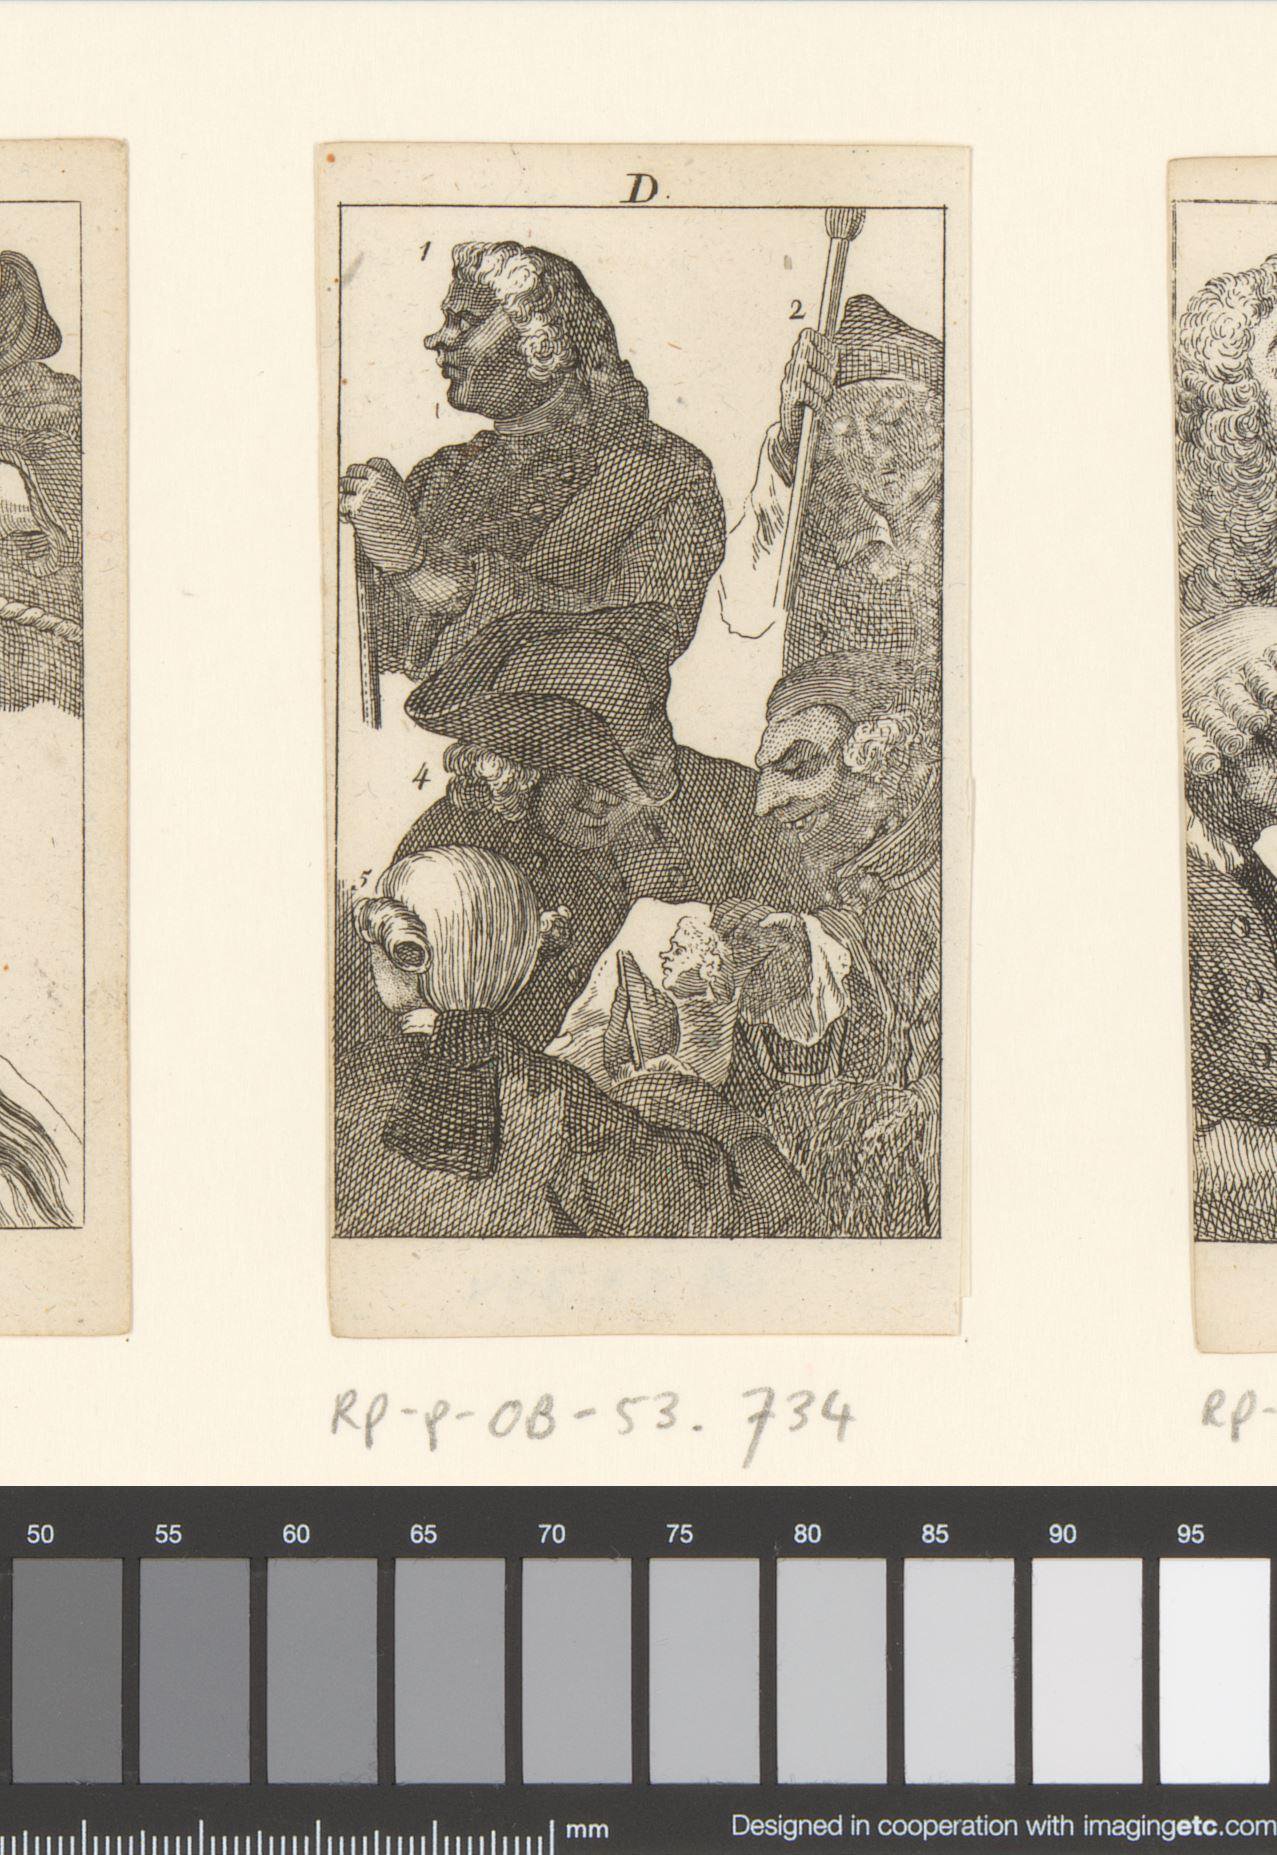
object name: print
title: Vier soldaten en een jurist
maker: ernst ludwig riepenhausen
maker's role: print maker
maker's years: 1765-1840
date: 1775-1840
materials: paper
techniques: etching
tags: adult man, the soldier; the soldier's life, magistracy, judges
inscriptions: collector's mark: Lugt 2228